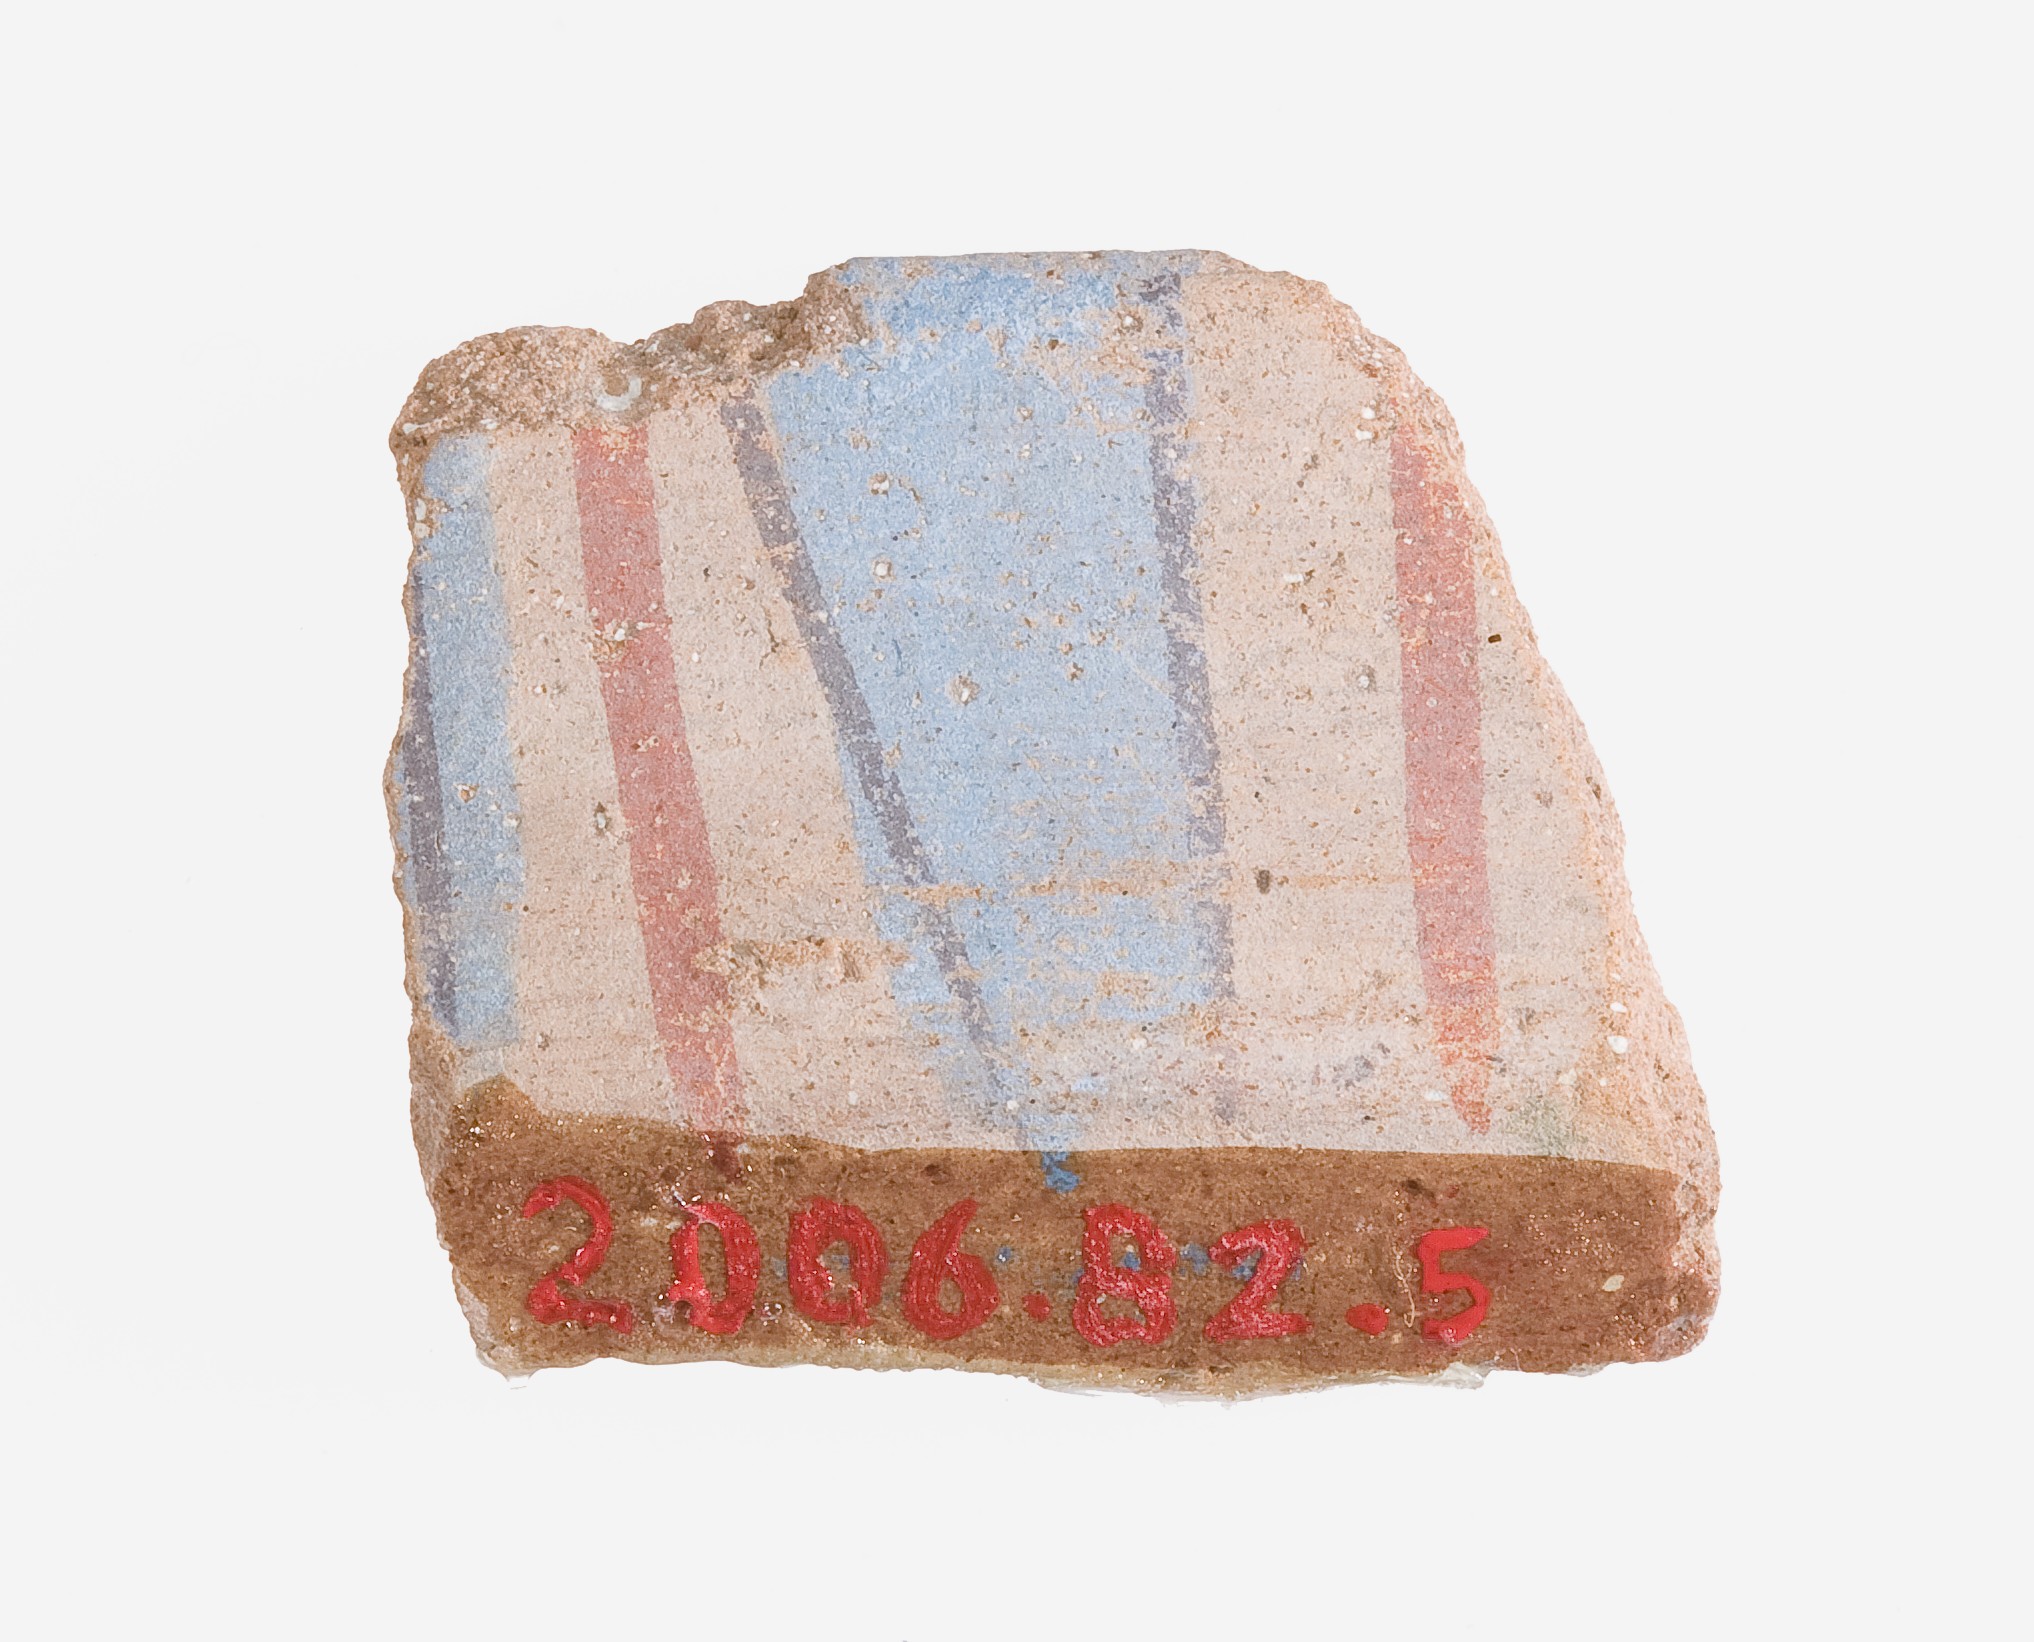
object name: vessel fragment, painted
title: Vessel fragment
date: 1390-1353 BCE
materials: paint, pottery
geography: egypt